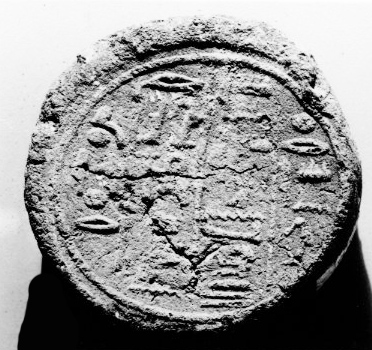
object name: cone, qenamun, circular impression, scribe of account, grain of amun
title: Funerary Cone of the Scribe of Accounts Qenamun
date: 1550-1295 BCE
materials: pottery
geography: egypt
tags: hieroglyphs